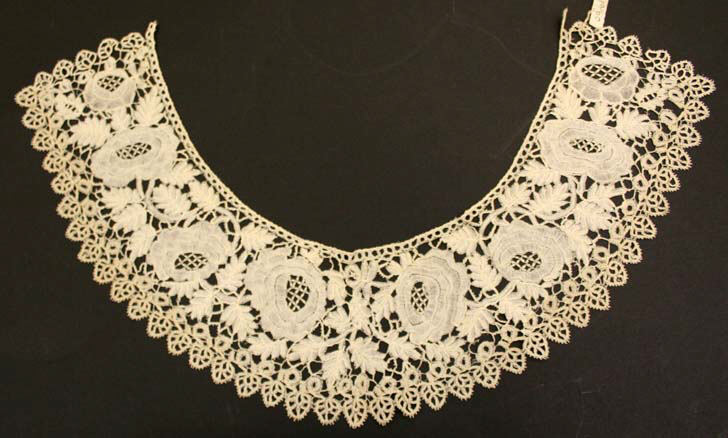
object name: collar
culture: british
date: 1801-1900